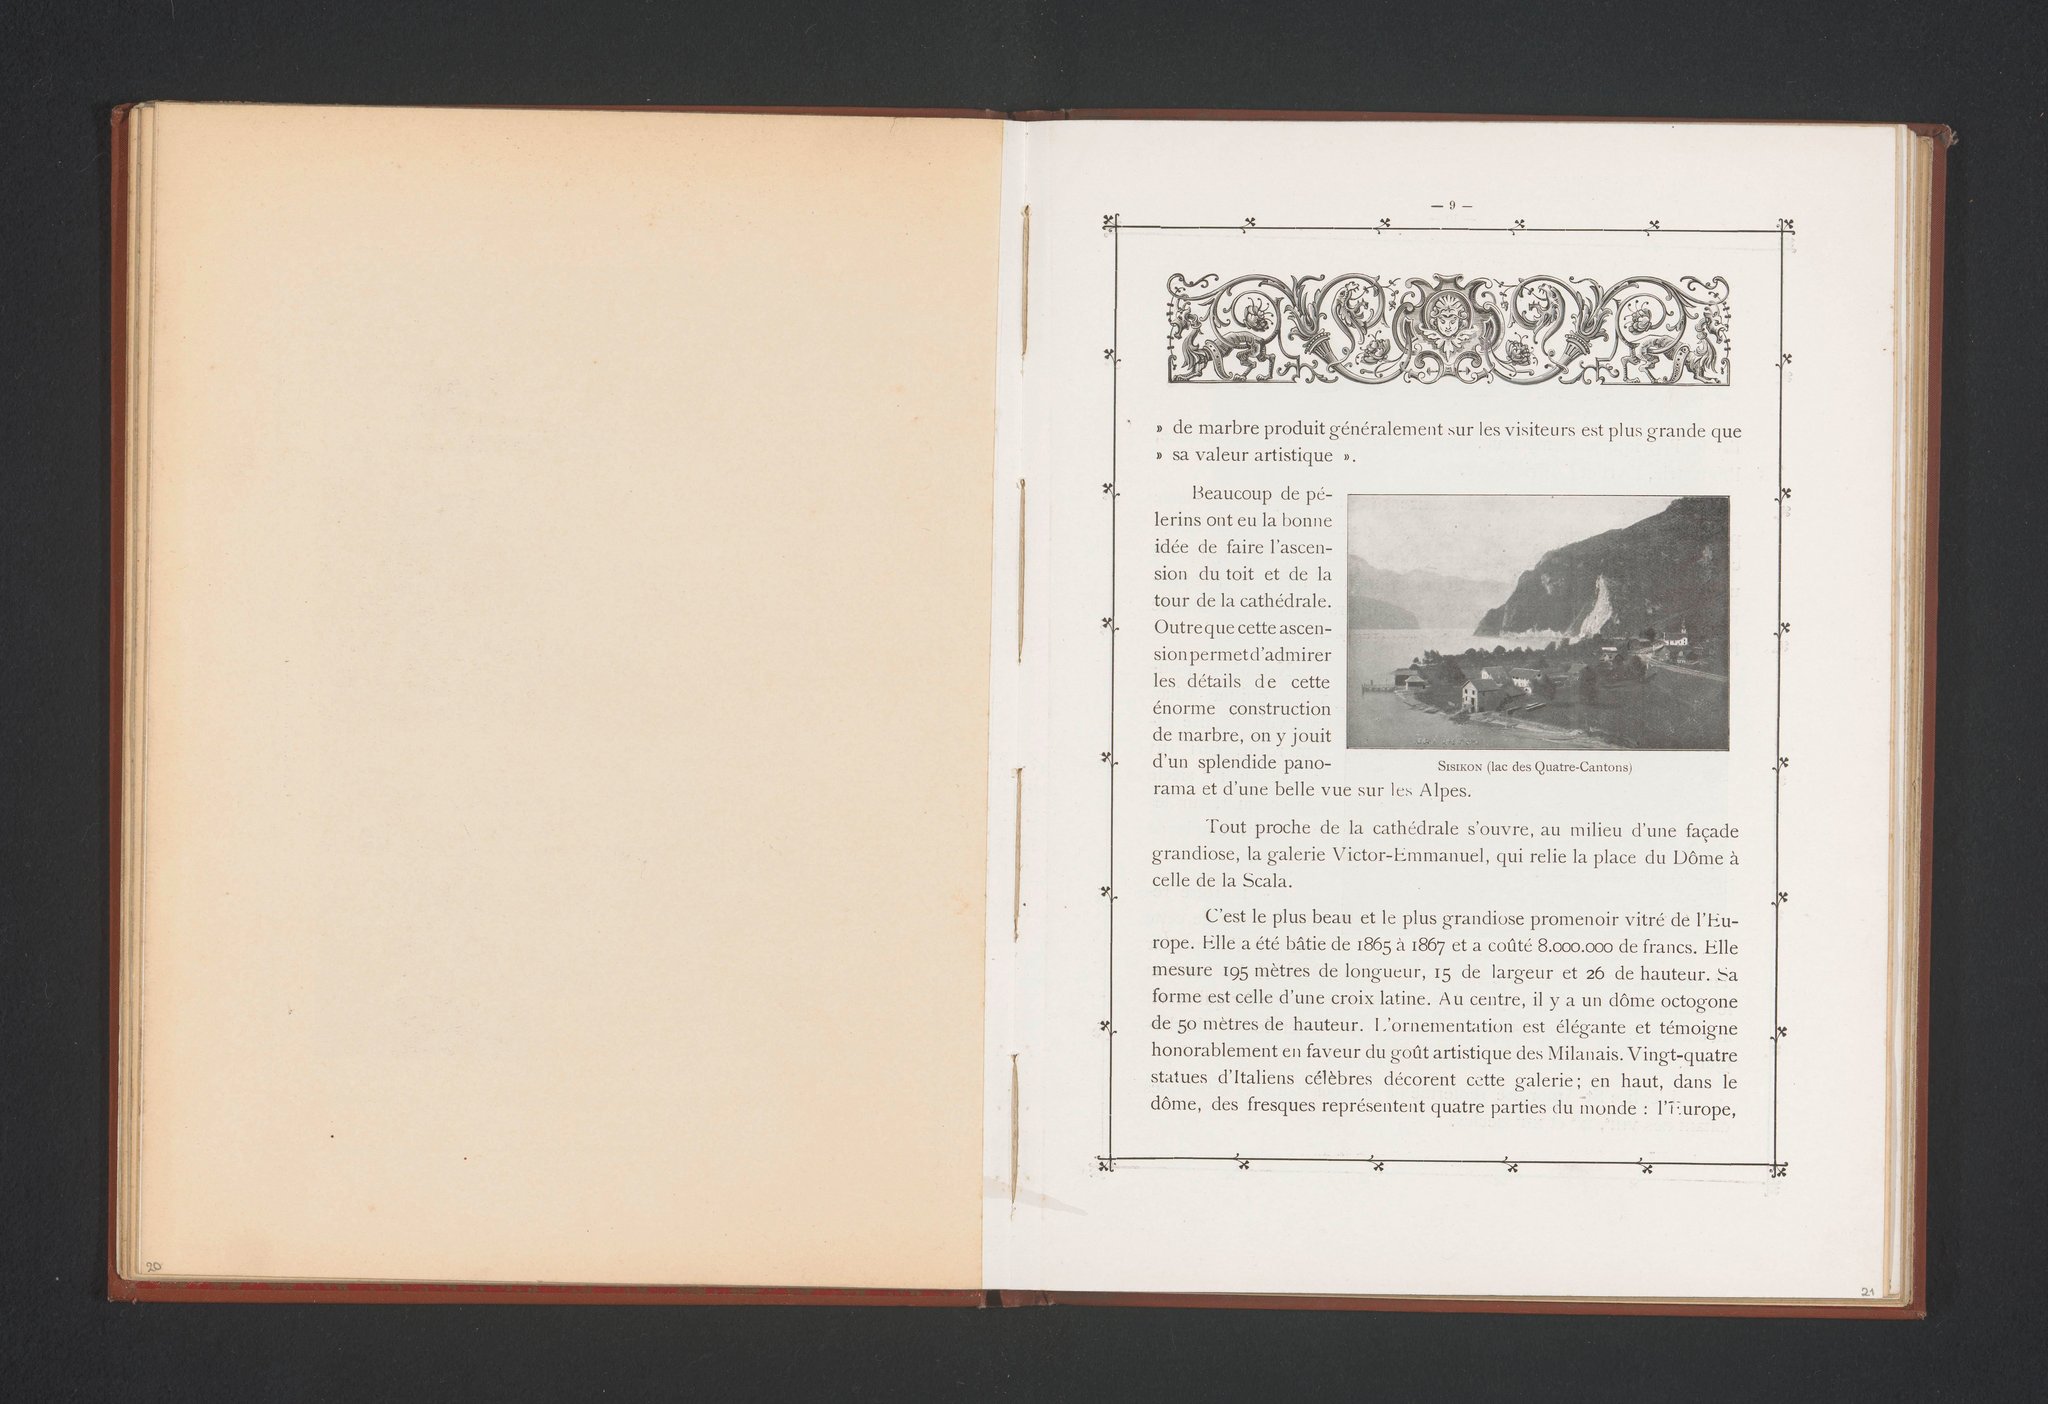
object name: photomechanical print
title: Gezicht op Sisikon aan het Vierwoudstrekenmeer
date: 1893-1898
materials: paper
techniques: autotype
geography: vierwoudstrekenmeer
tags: prospect of village, silhouette of village, lake, mountains